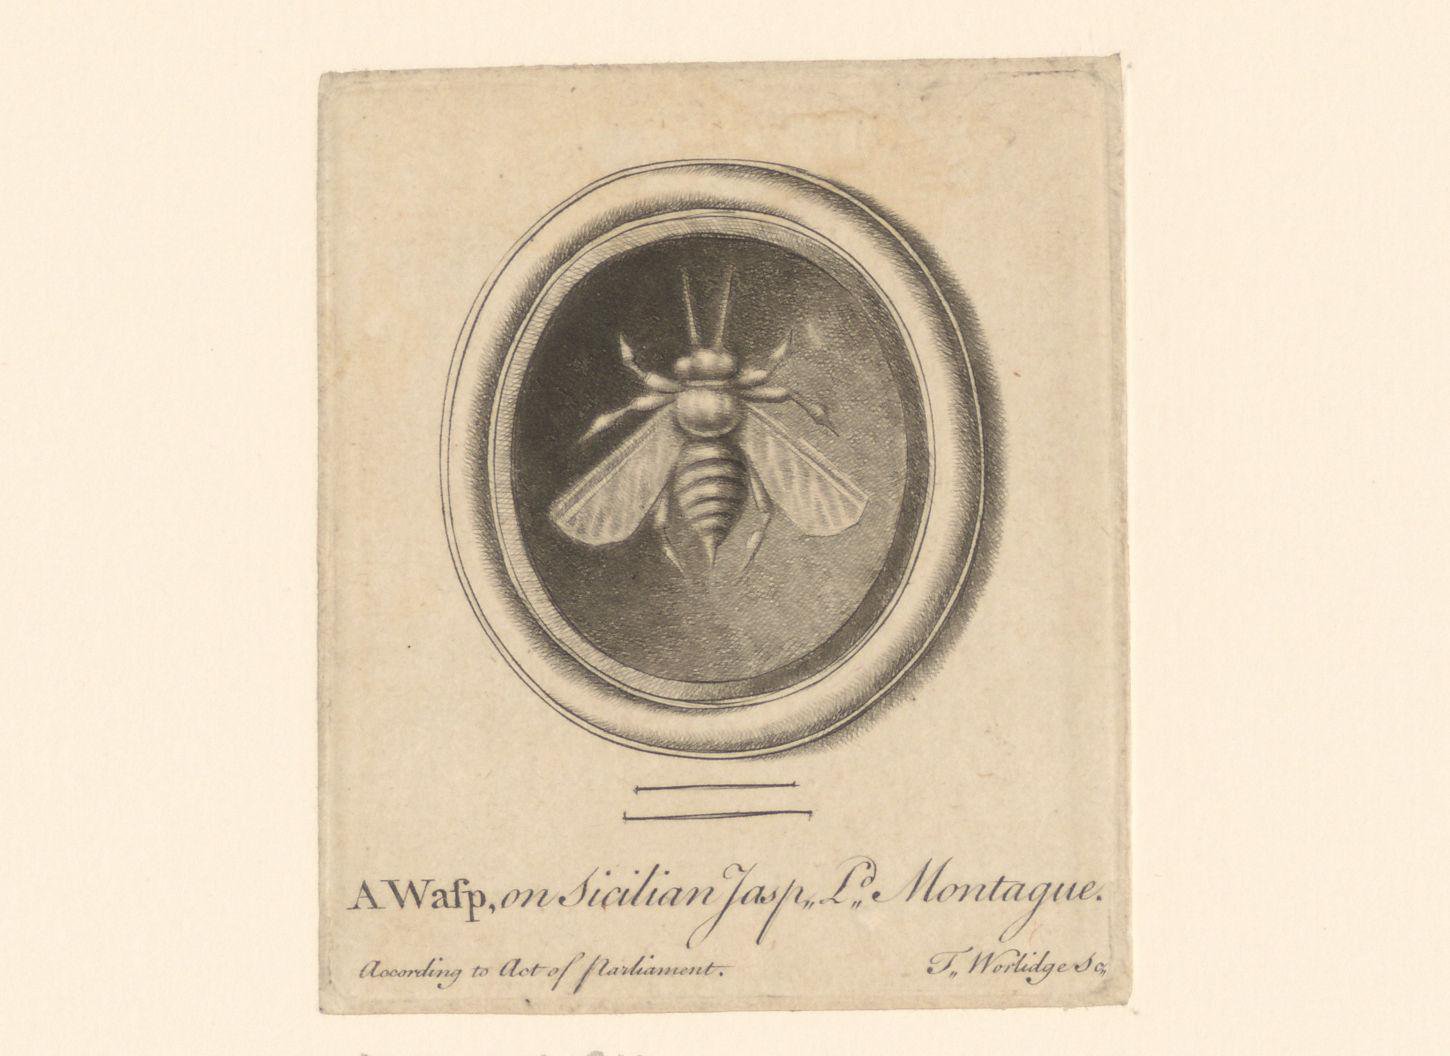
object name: print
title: Prenten naar antieke edelstenen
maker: thomas worlidge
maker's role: print maker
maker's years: 1700-1766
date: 1768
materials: paper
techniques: drypoint, etching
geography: england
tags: precious and semiprecious stones: jasper, insects: wasp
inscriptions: collector's mark: Lugt 2228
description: Worlidge maakte prenten voor de serie vanaf ca. 1754. Na zijn dood werden de prenten gebundeld in: Worlidge, Thomas. A Select Collection of Drawings from Curious Antique Gems (...). Londen: M. Worlidge, 1768.